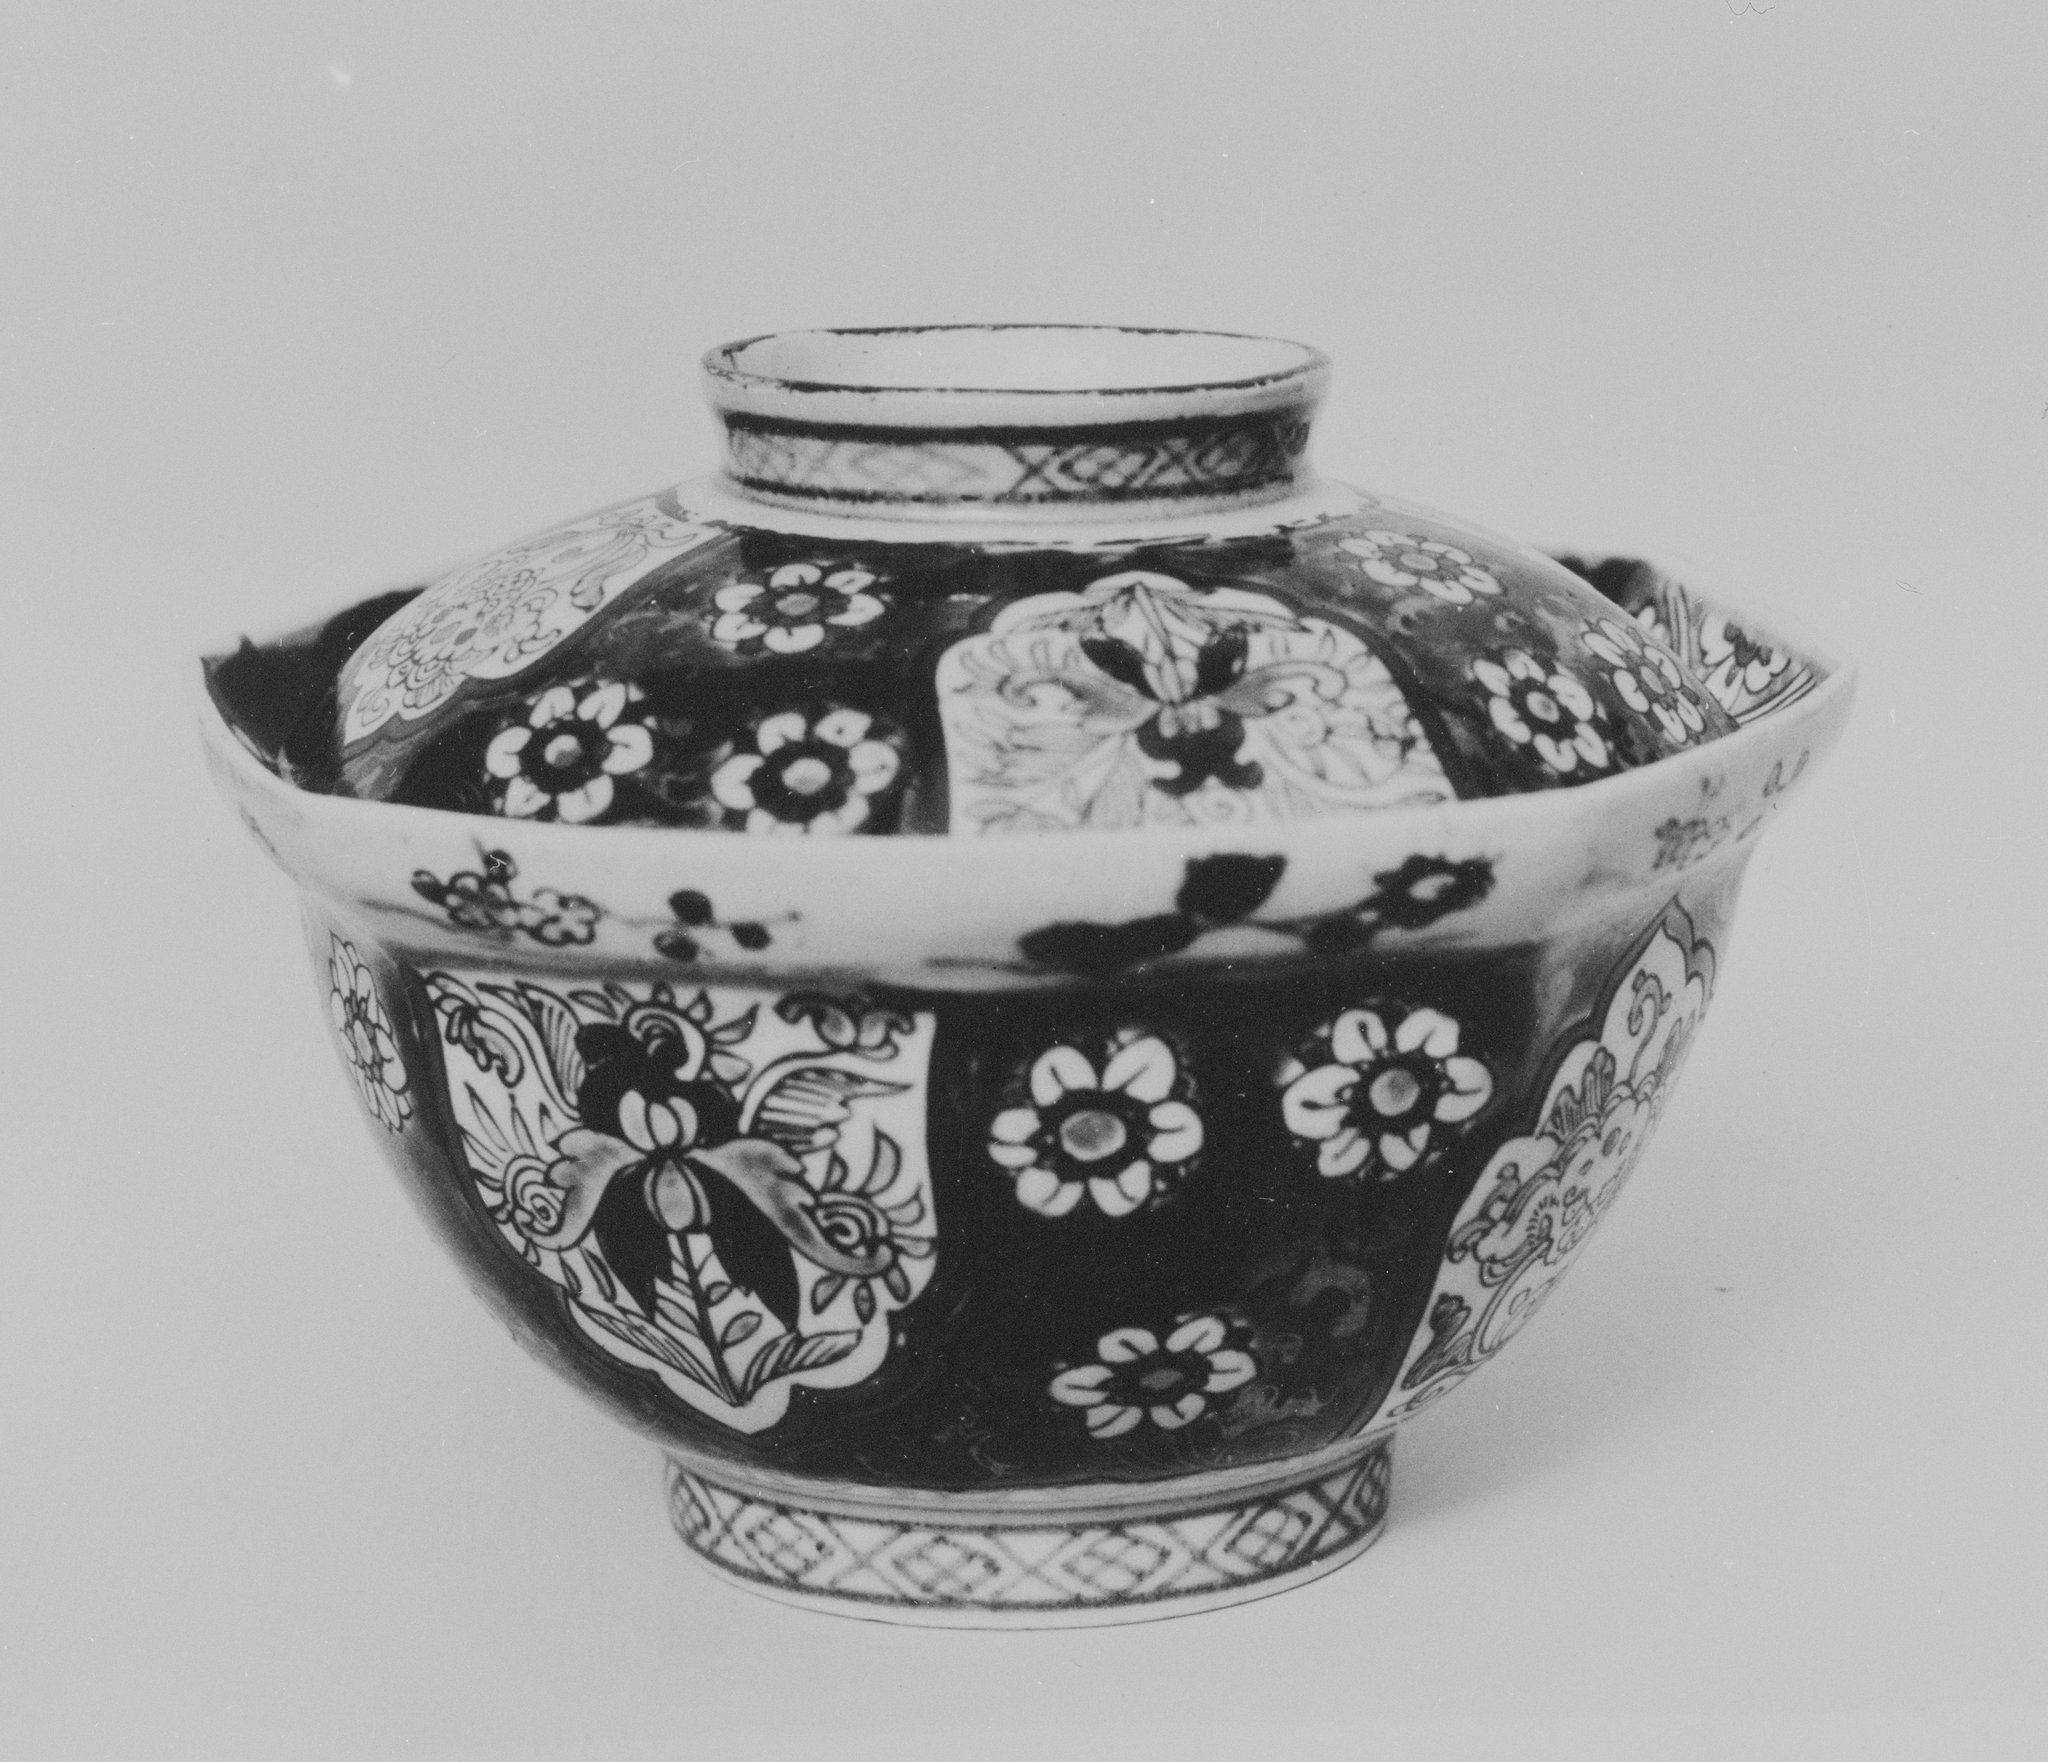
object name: covered bowl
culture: japanese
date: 1750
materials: enamel, porcelain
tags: flowers